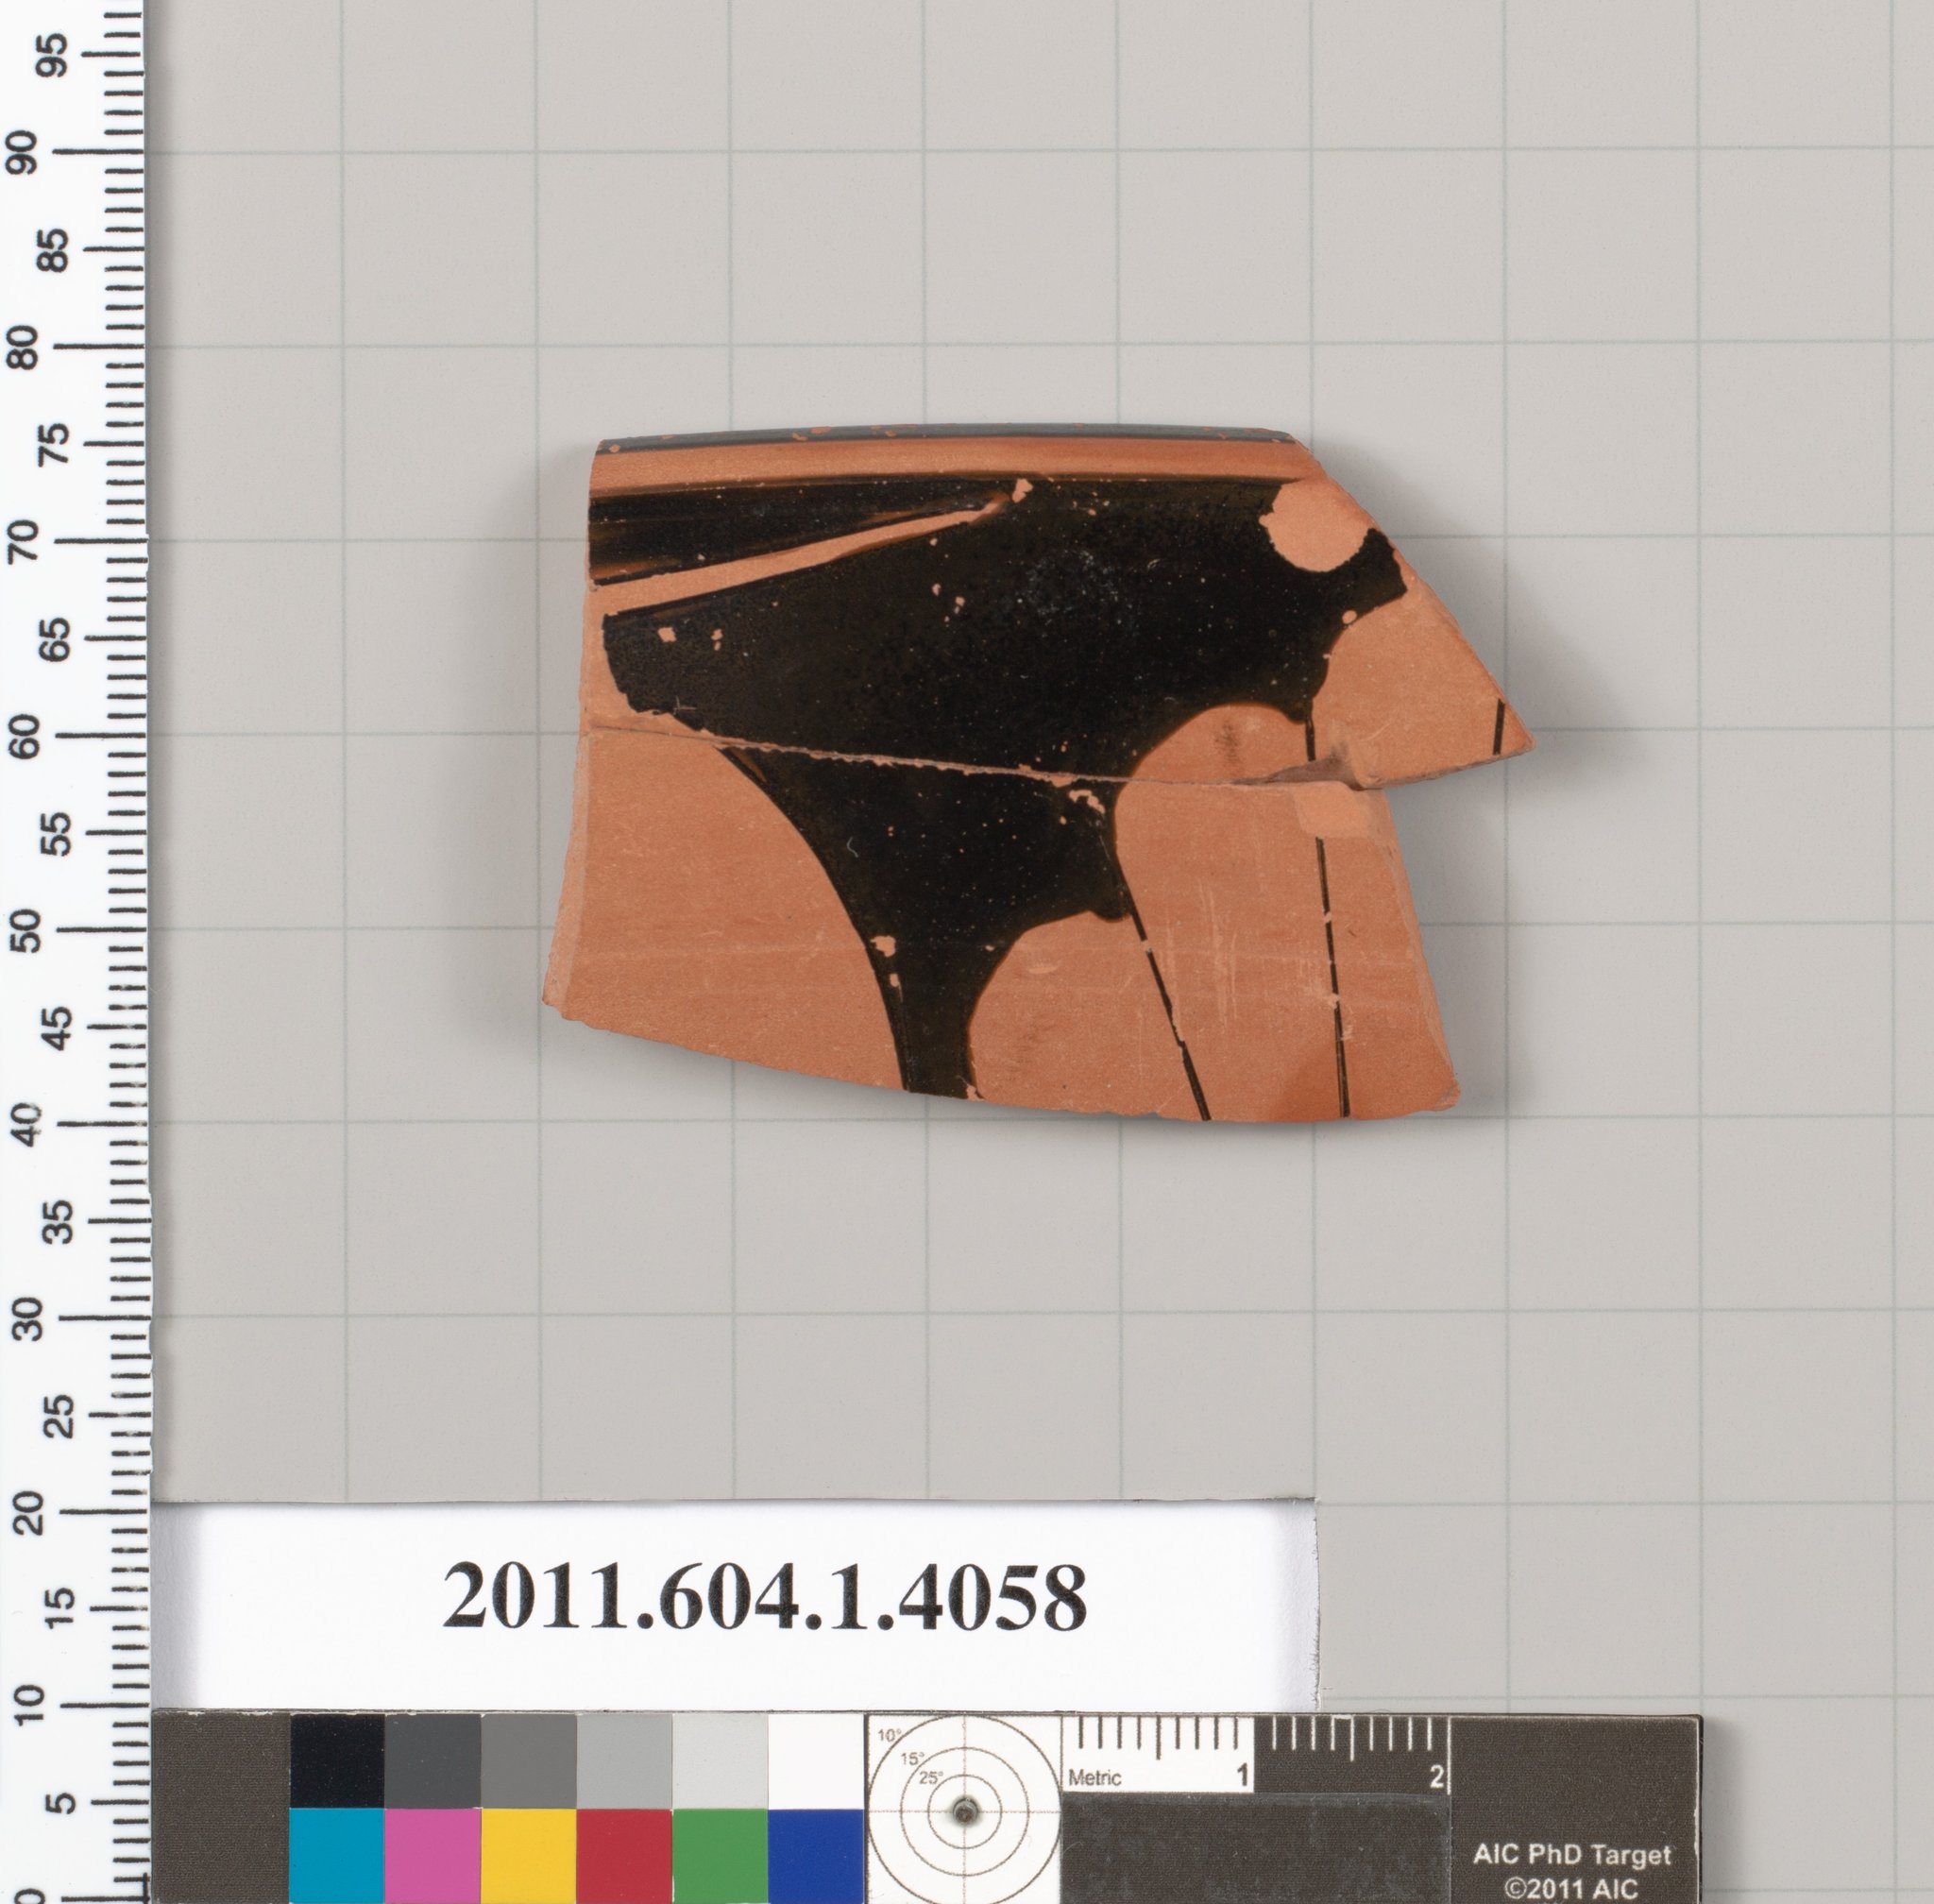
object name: kylix fragment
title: Terracotta rim fragment of a kylix (drinking cup)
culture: greek, attic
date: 534-468 BCE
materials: terracotta